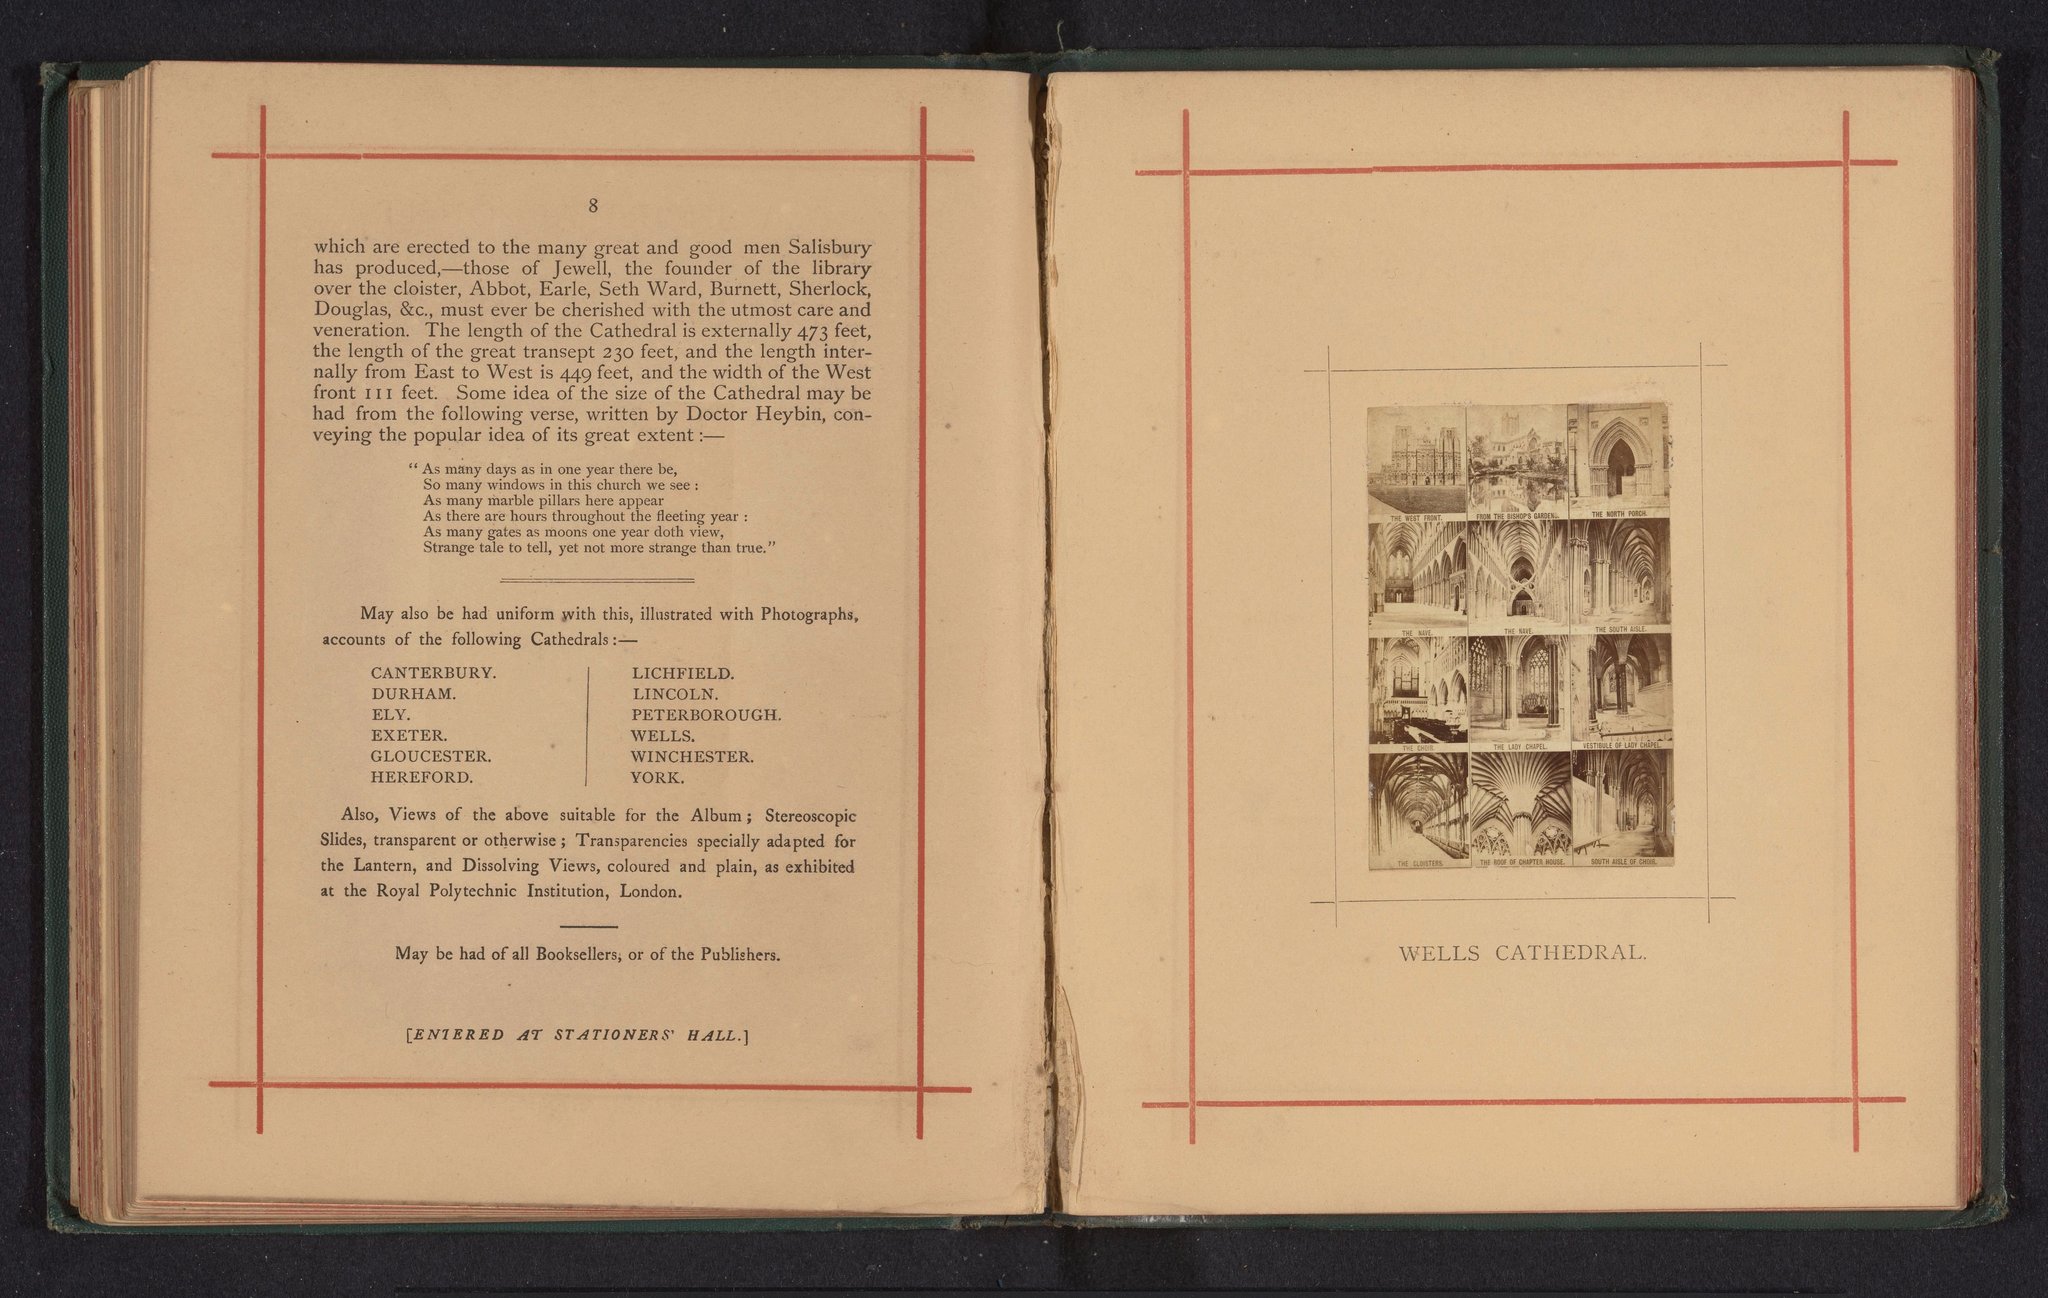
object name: page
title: Wells Cathedral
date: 1870-1880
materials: photographic support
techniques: albumen print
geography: wells cathedral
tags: church (exterior), parts of church interior: nave, cloisters ~ monastery, parts of church interior: choir, parts of church interior: chapel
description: Van boven naar beneden en van links naar rechts: tweemaal een gezicht op de kathedraal, het noordportaal, tweemaal het schip, een zijbeuk, het koor, tweemaal een kapel, een kloostergang, het dak van de kapittelzaal en een zijbeuk van het koor.